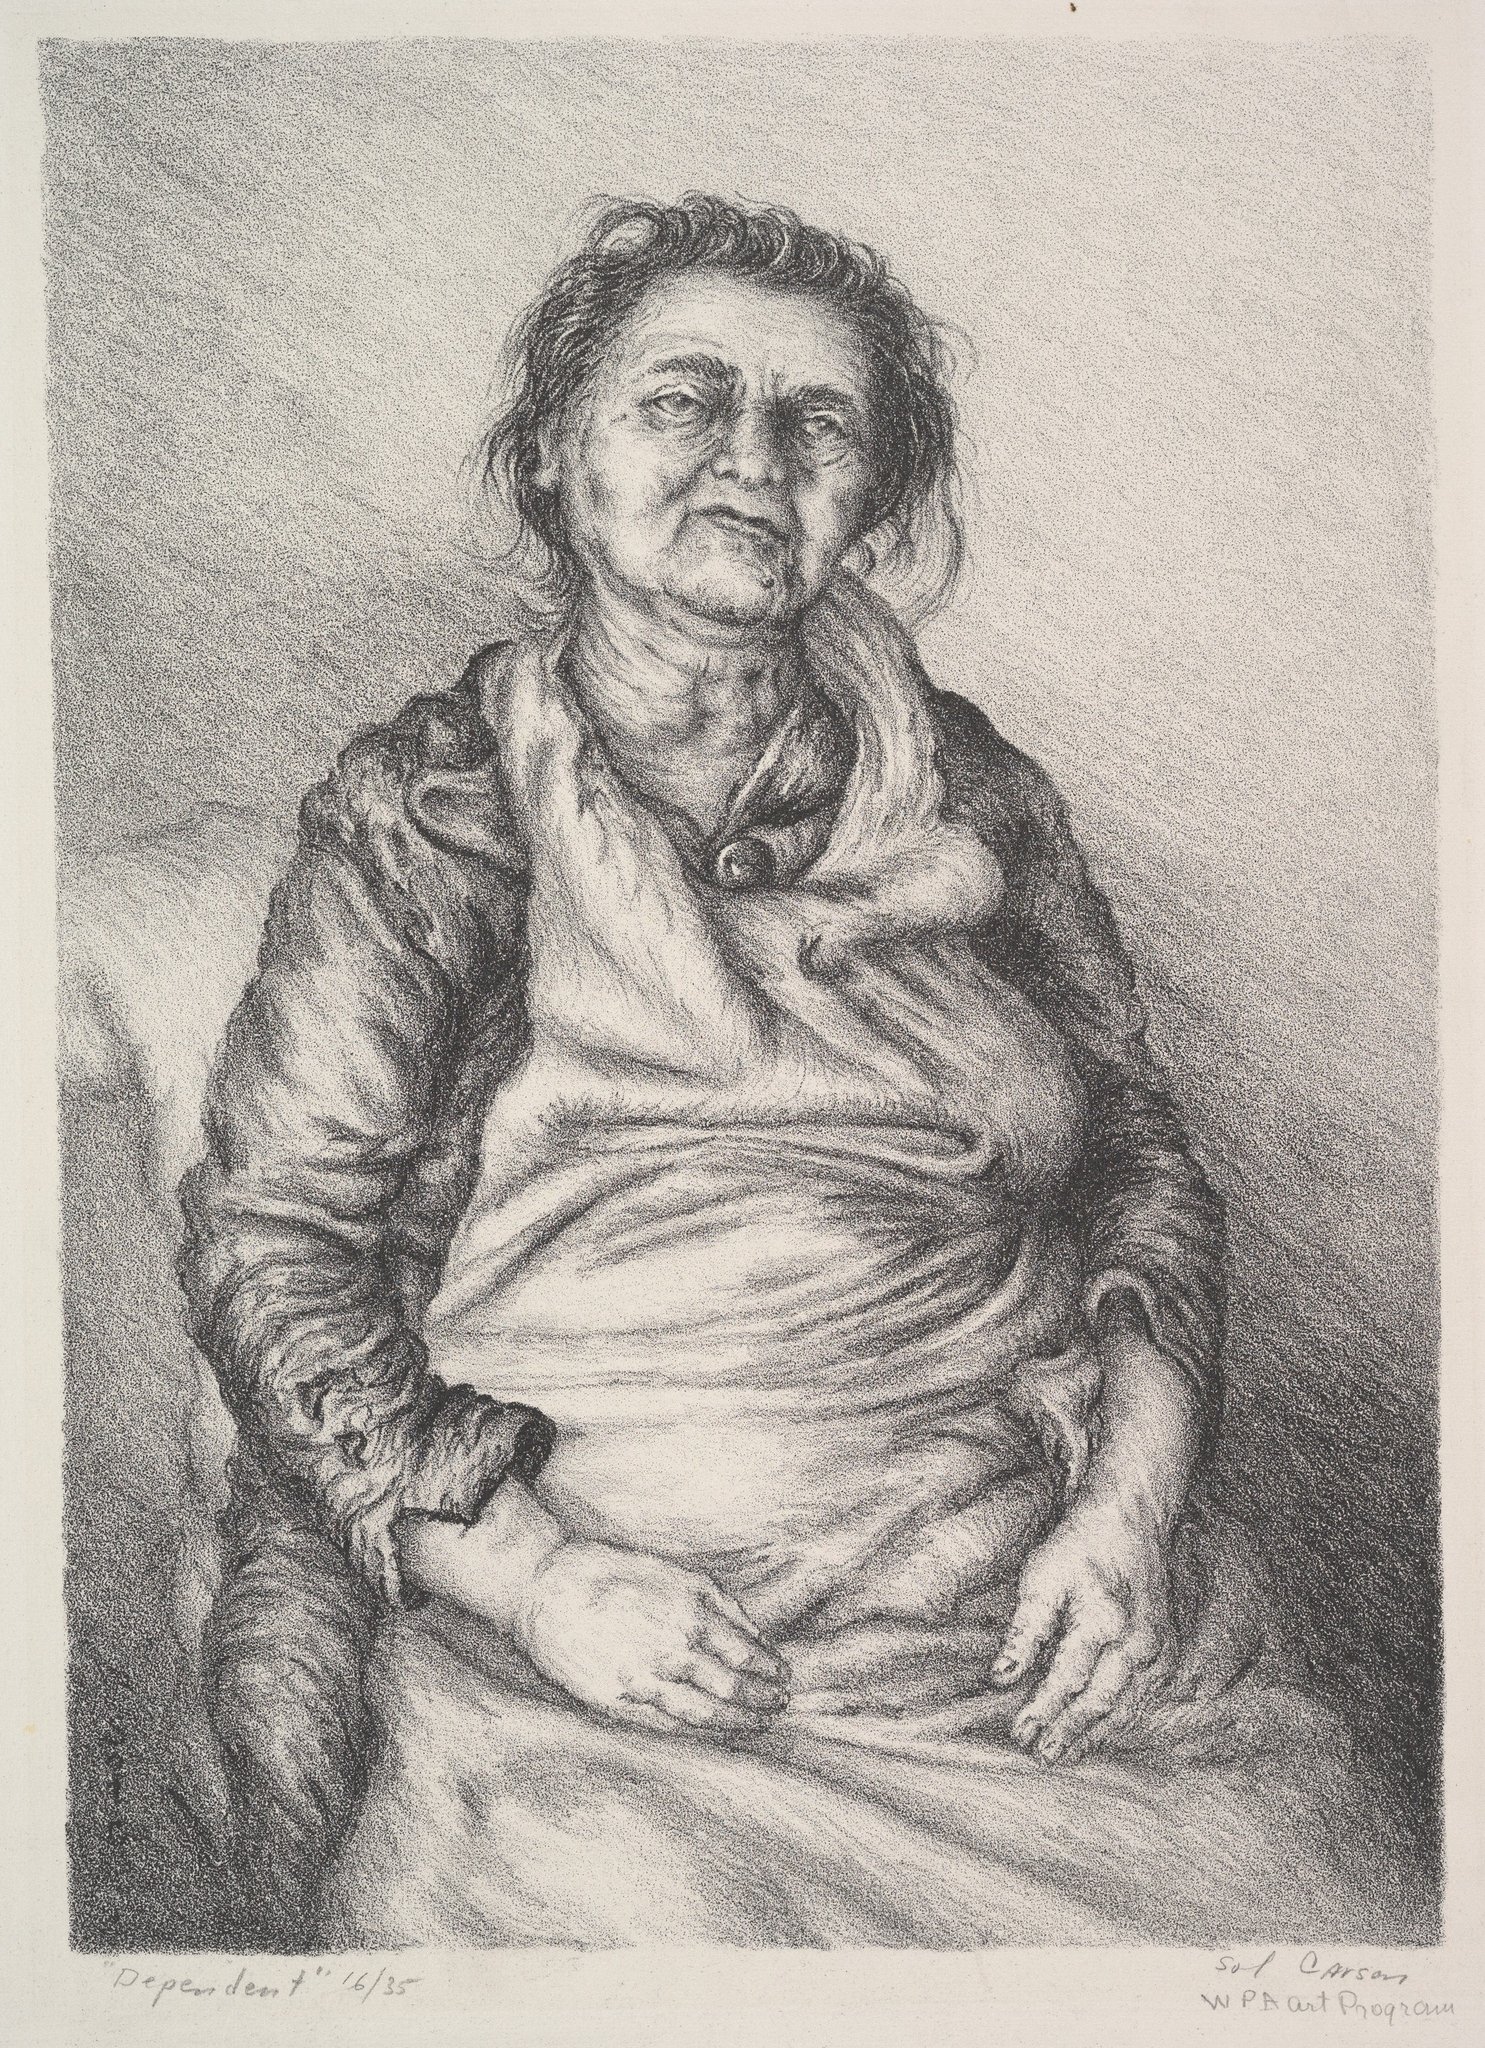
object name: print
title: Dependent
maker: sol carson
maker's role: artist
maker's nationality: american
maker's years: 1917-2017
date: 1935-1943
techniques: lithograph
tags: women